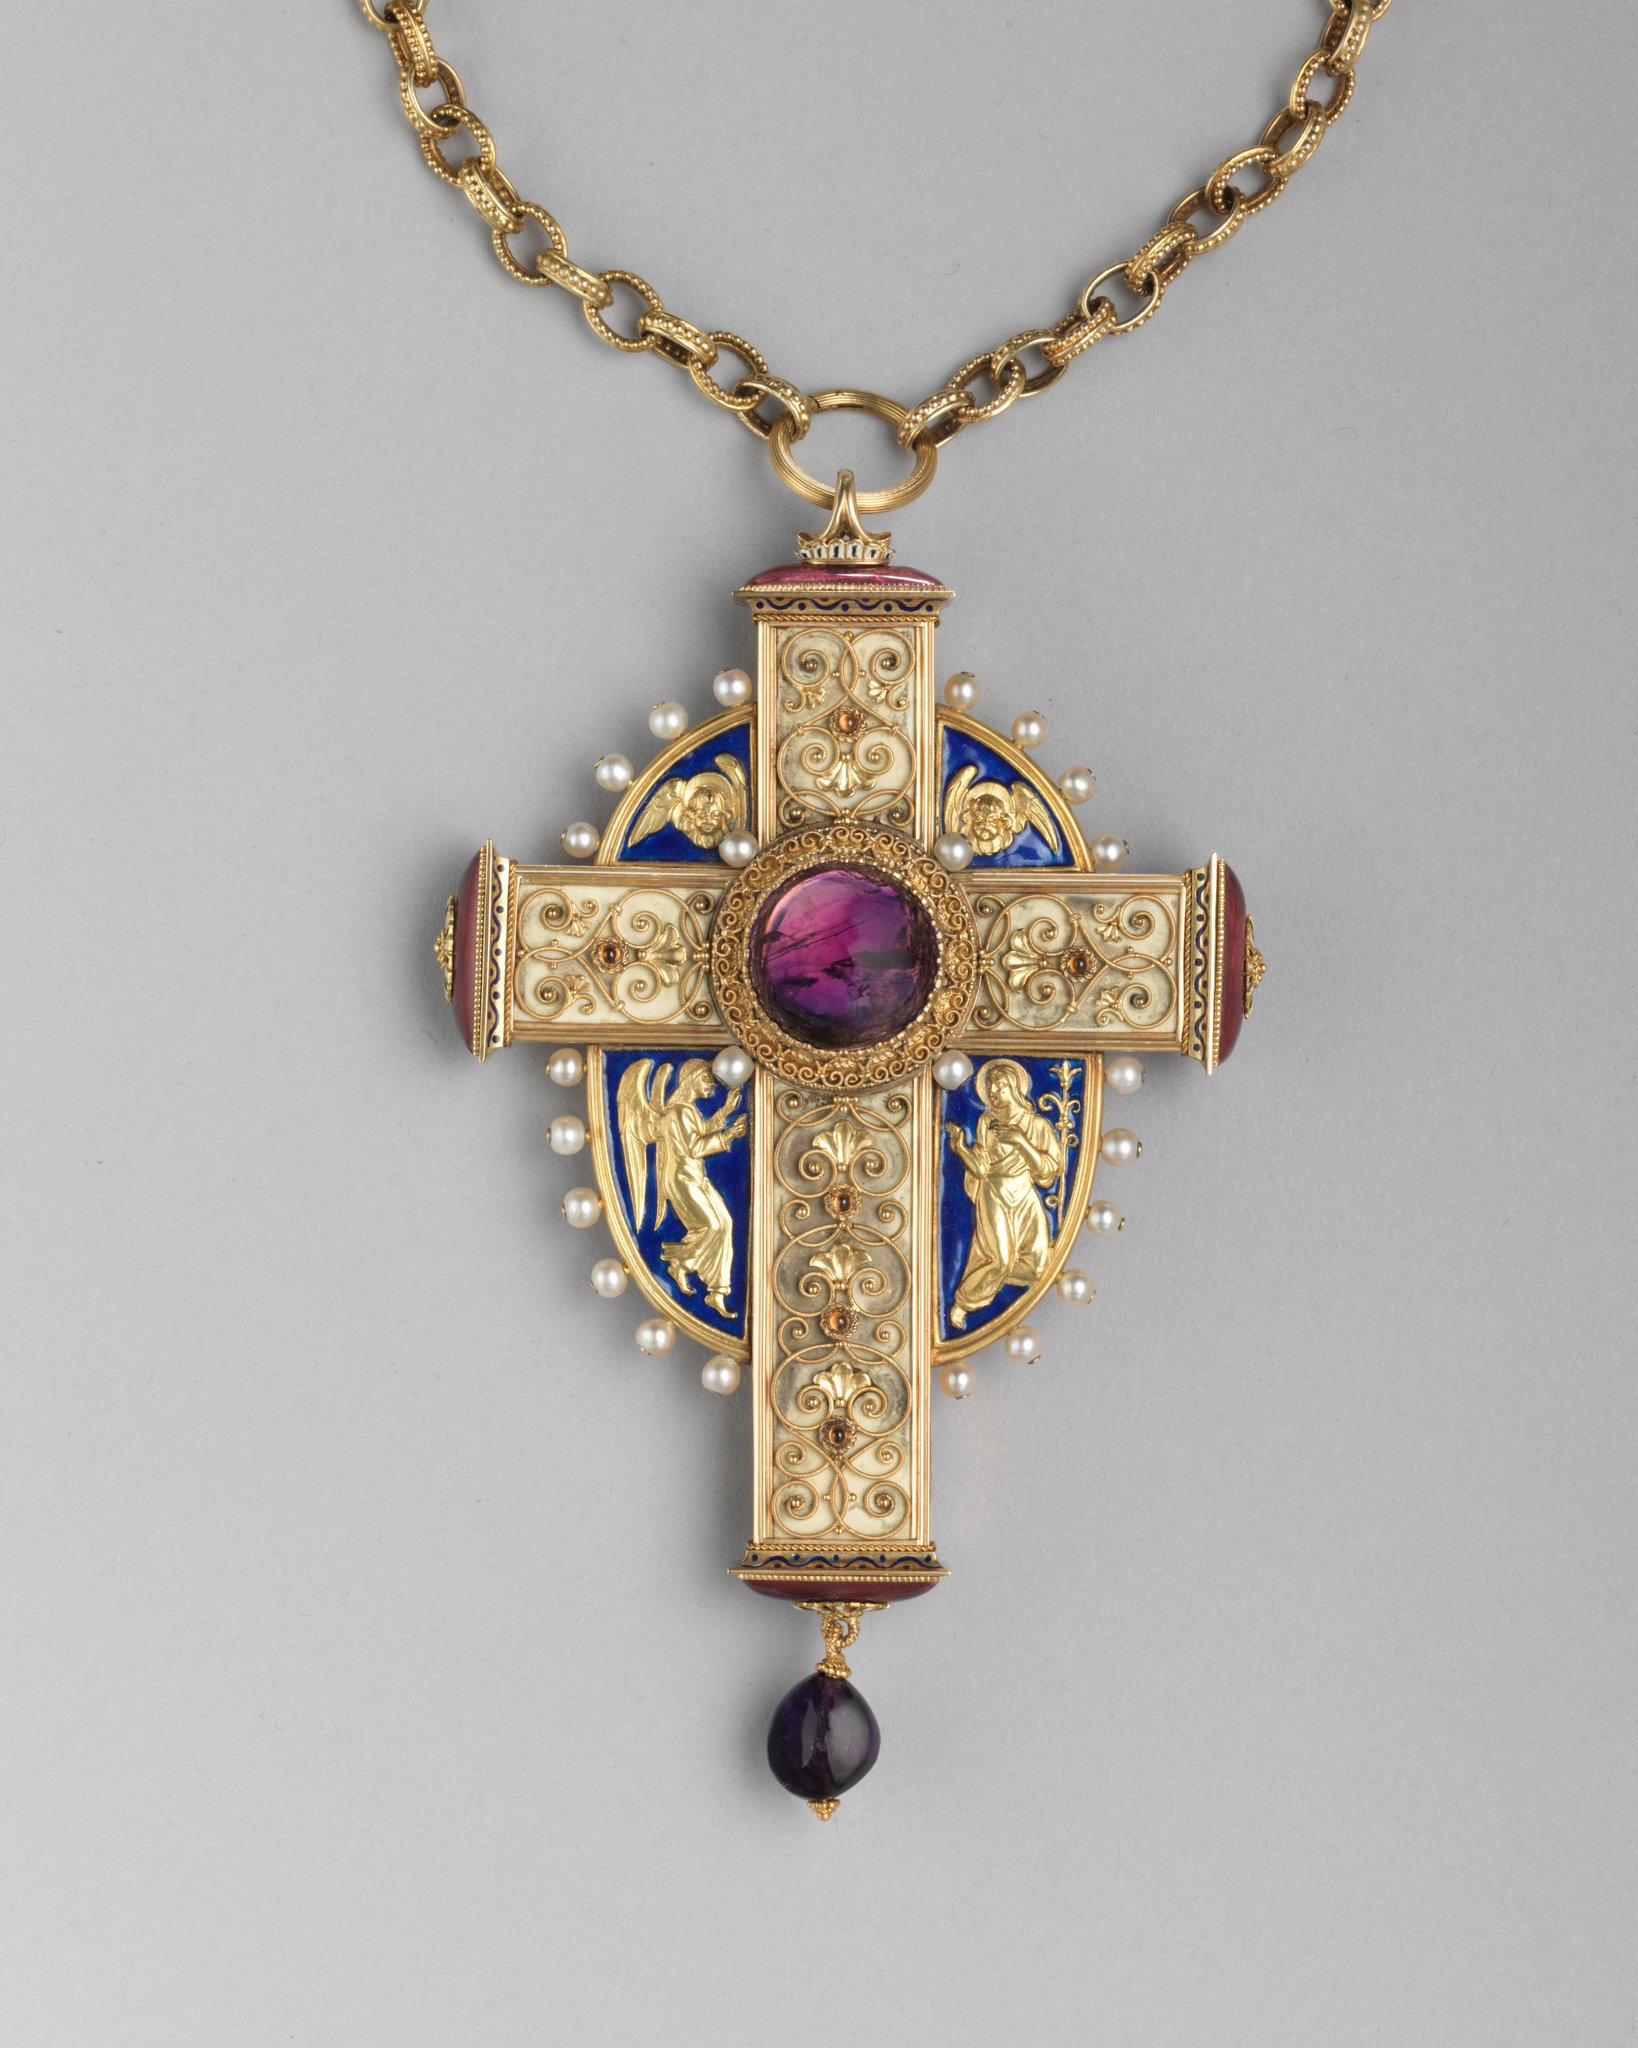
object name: pectoral cross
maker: hemmerle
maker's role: maker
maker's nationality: german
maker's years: 1893-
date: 1900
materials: amethyst, stone, enamel, gold, pearl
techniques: filigree